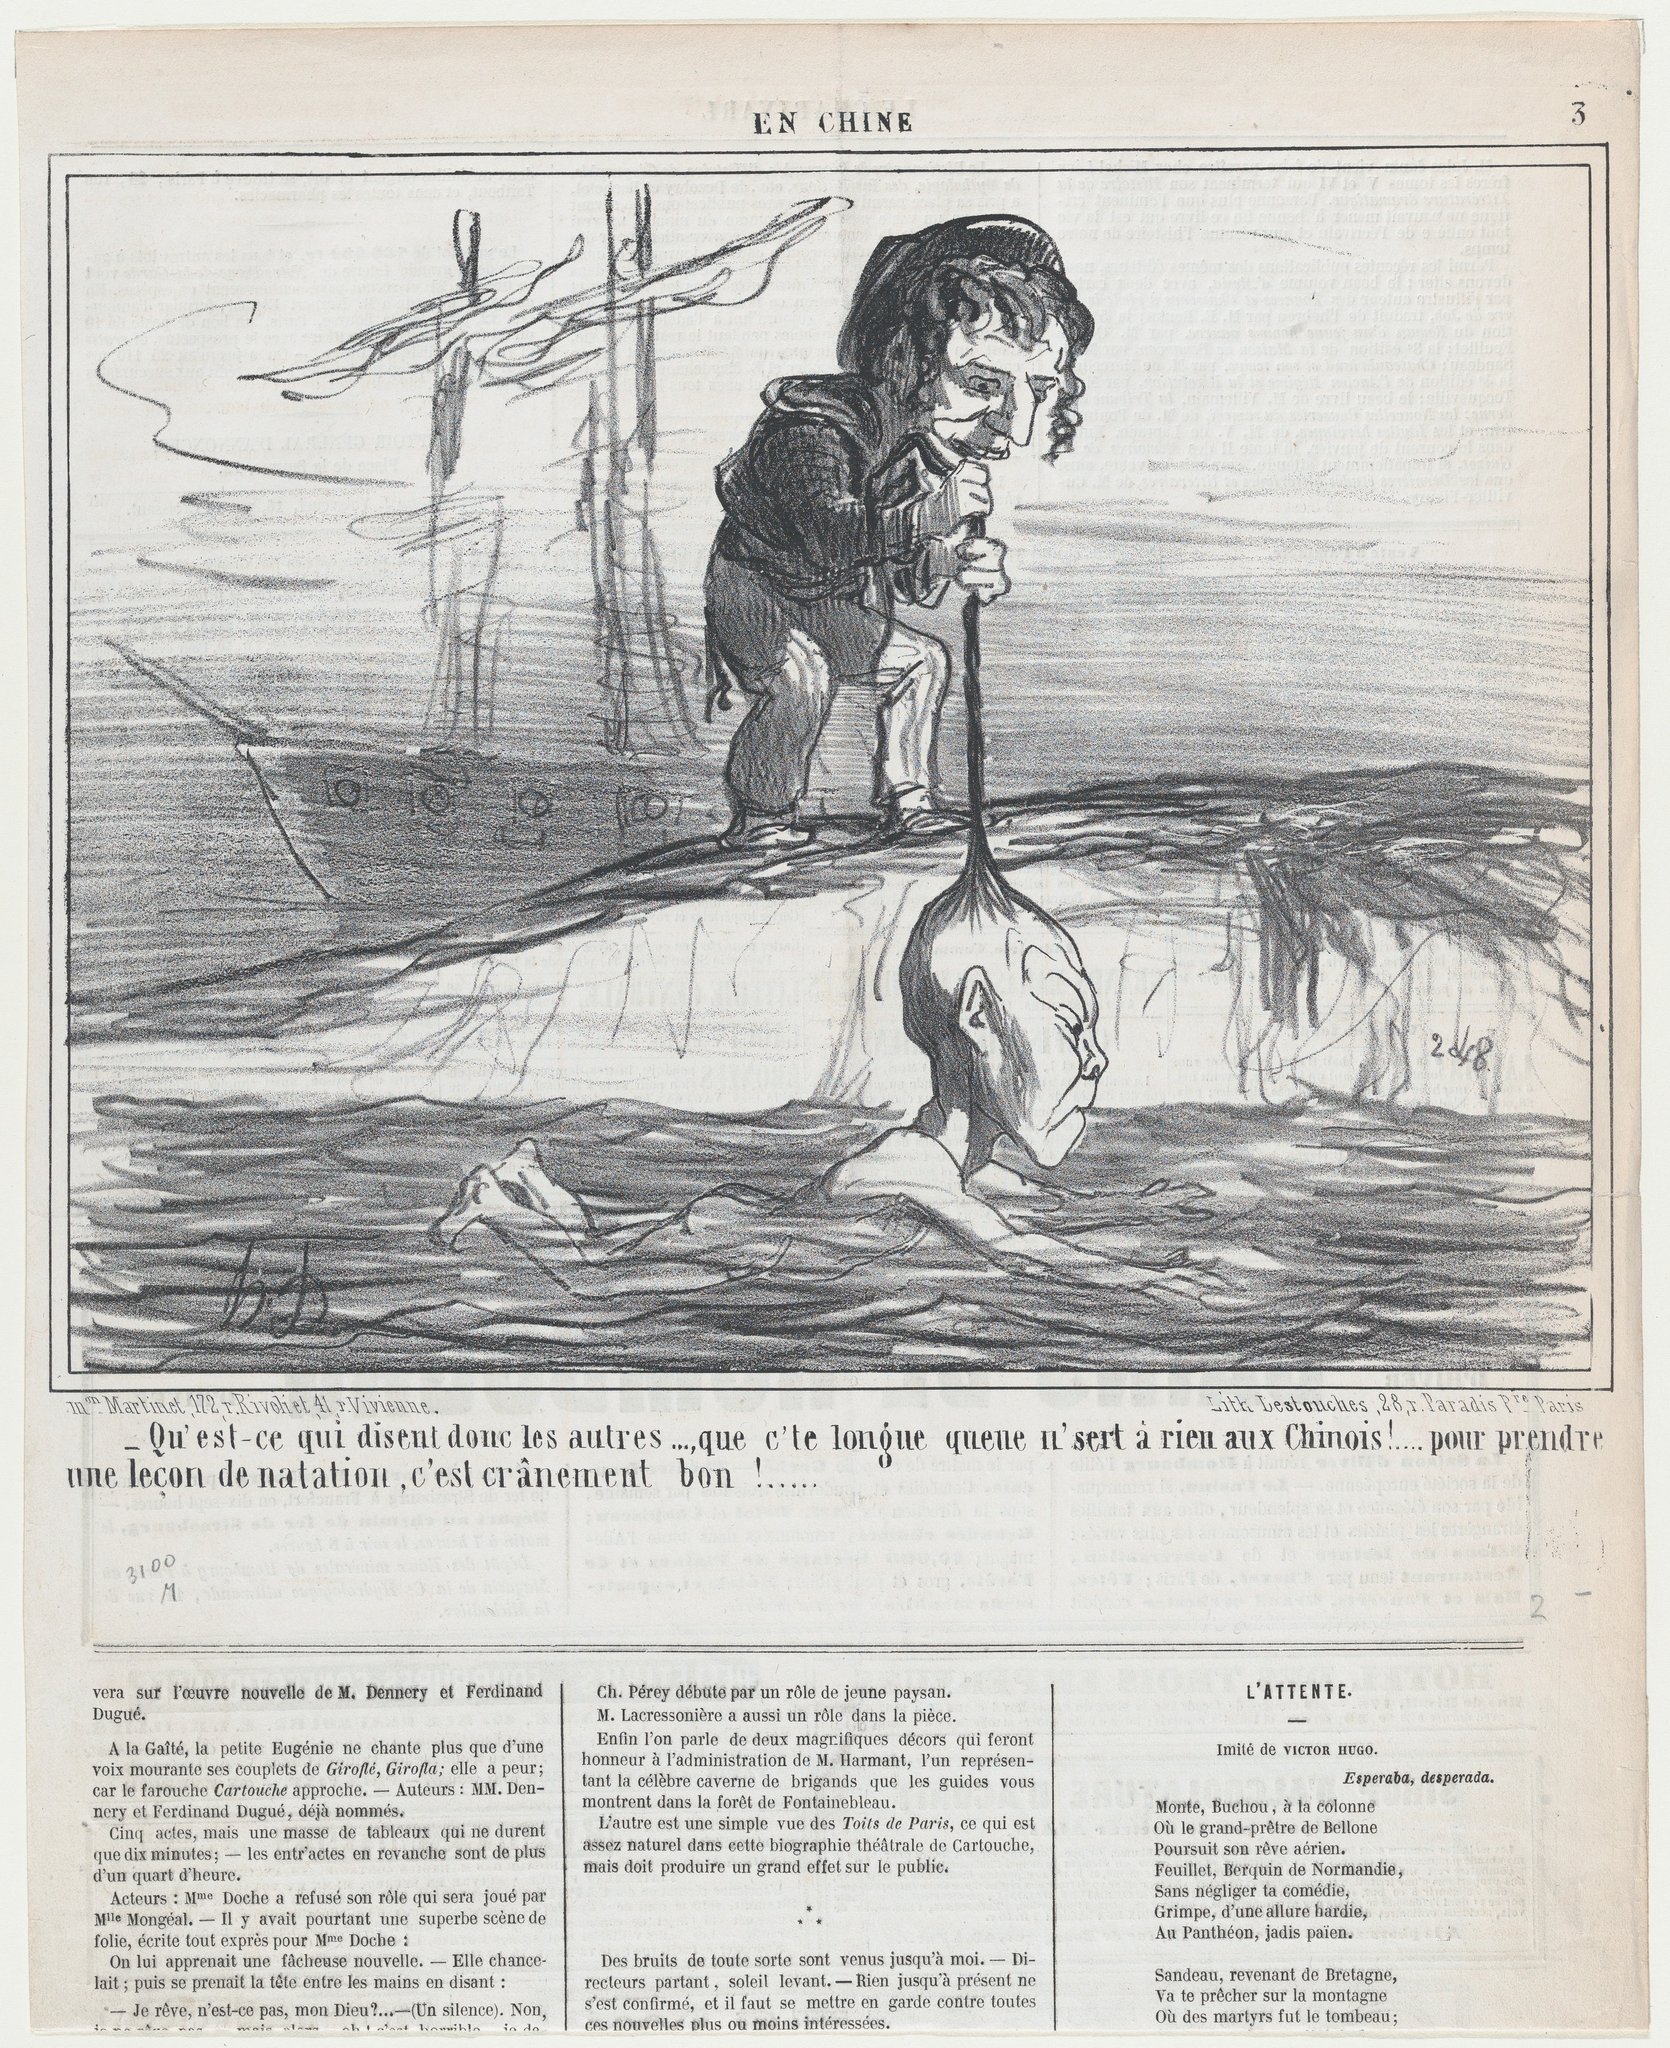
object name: print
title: Qu-est-ce qui disent donc les autres..., from En Chine, published in Le Charivari, December 20, 1858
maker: honoré daumier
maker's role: artist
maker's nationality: french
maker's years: 1808-1879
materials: paper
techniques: lithograph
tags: satire,men,boats